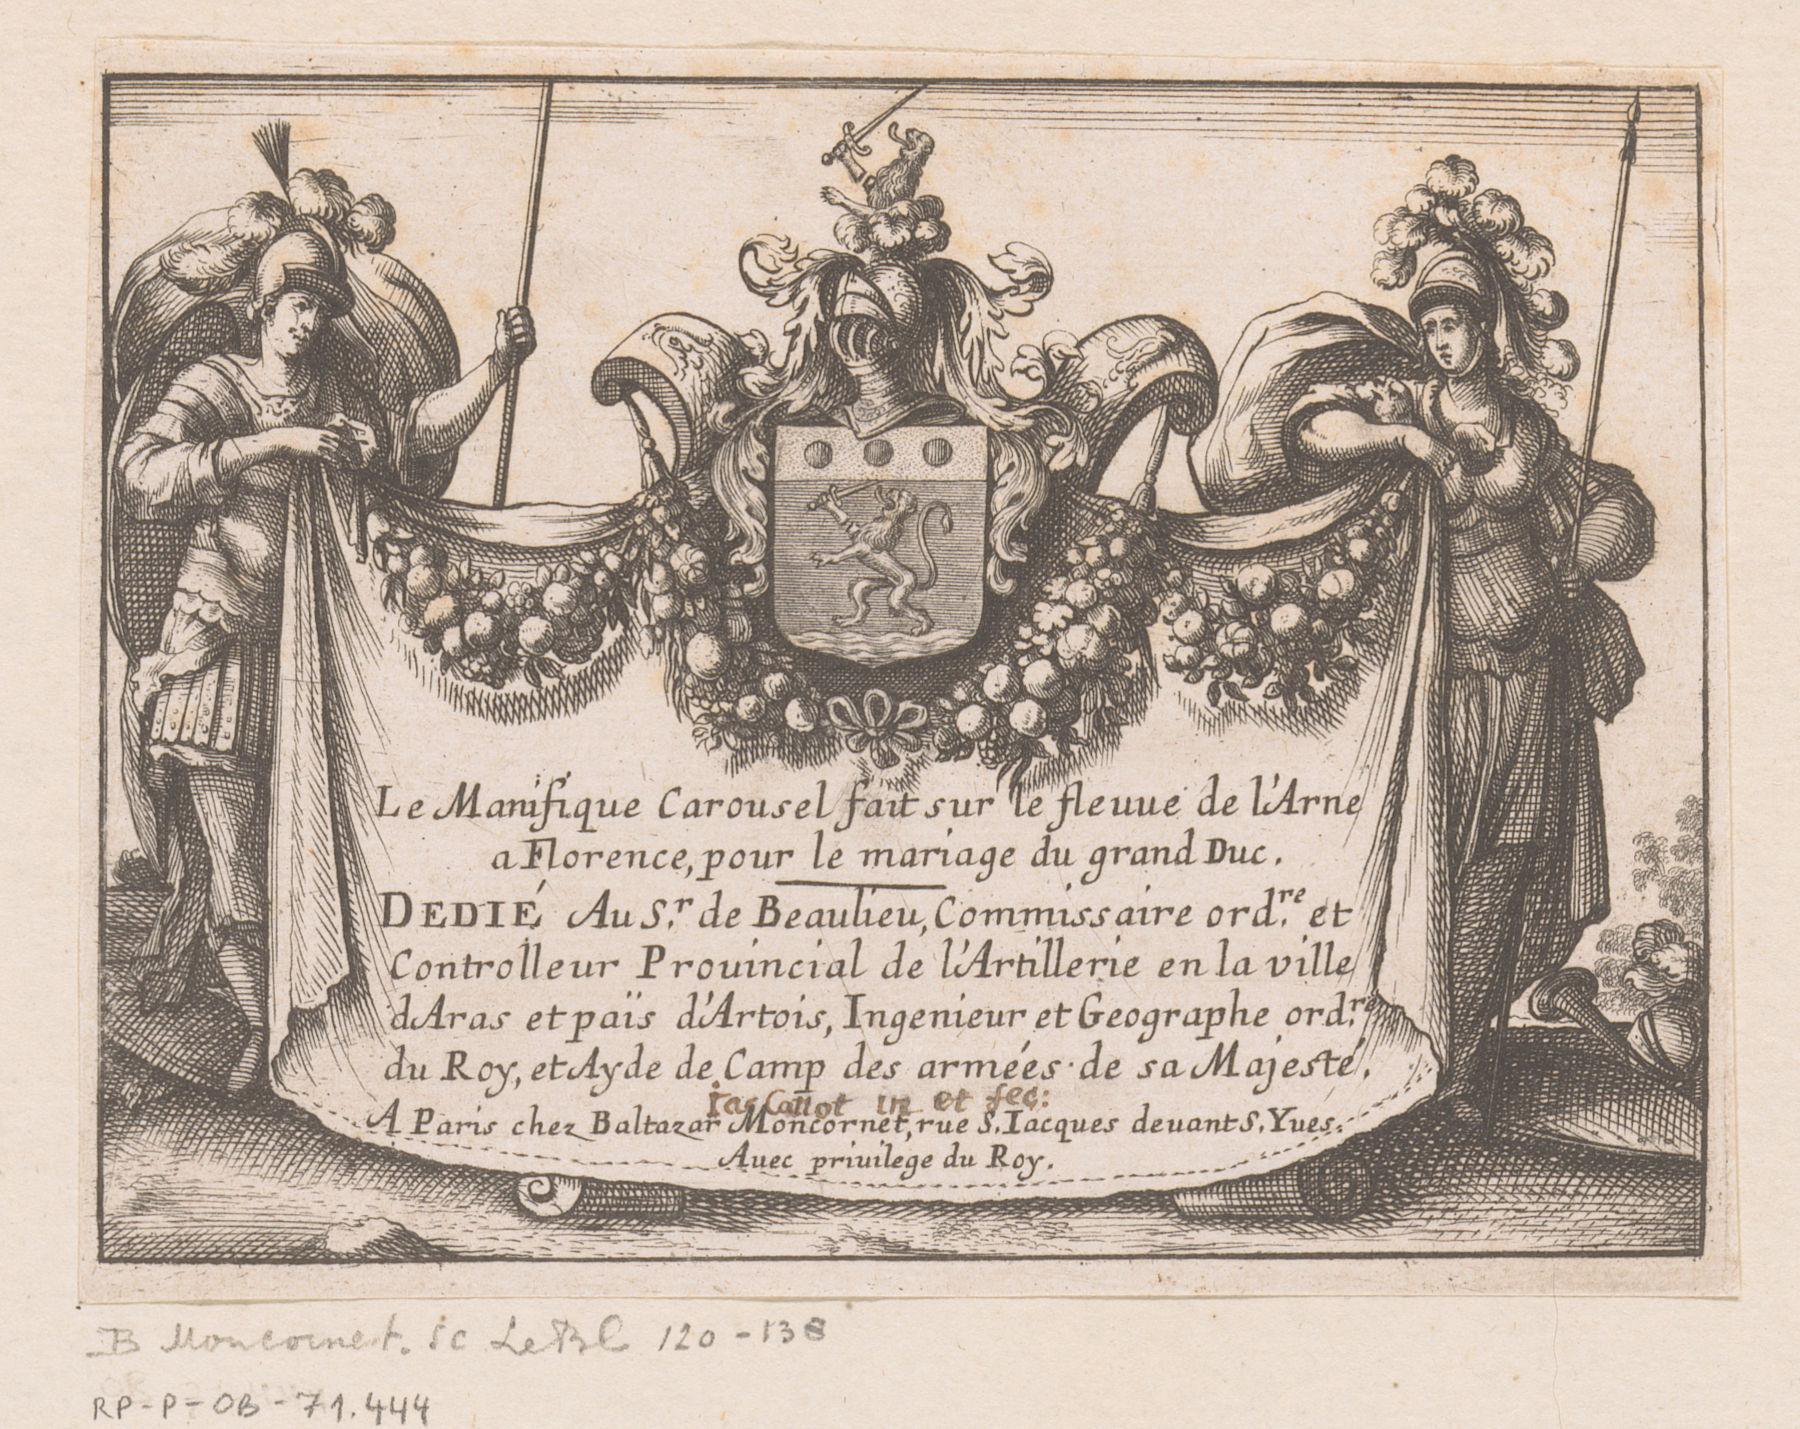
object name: titelprent, frontispice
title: Titelprent met een man en vrouw aan weerszijden van een wapenschild met festoenen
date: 1610-1668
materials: paper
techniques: engraving, etching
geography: paris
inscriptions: collector's mark